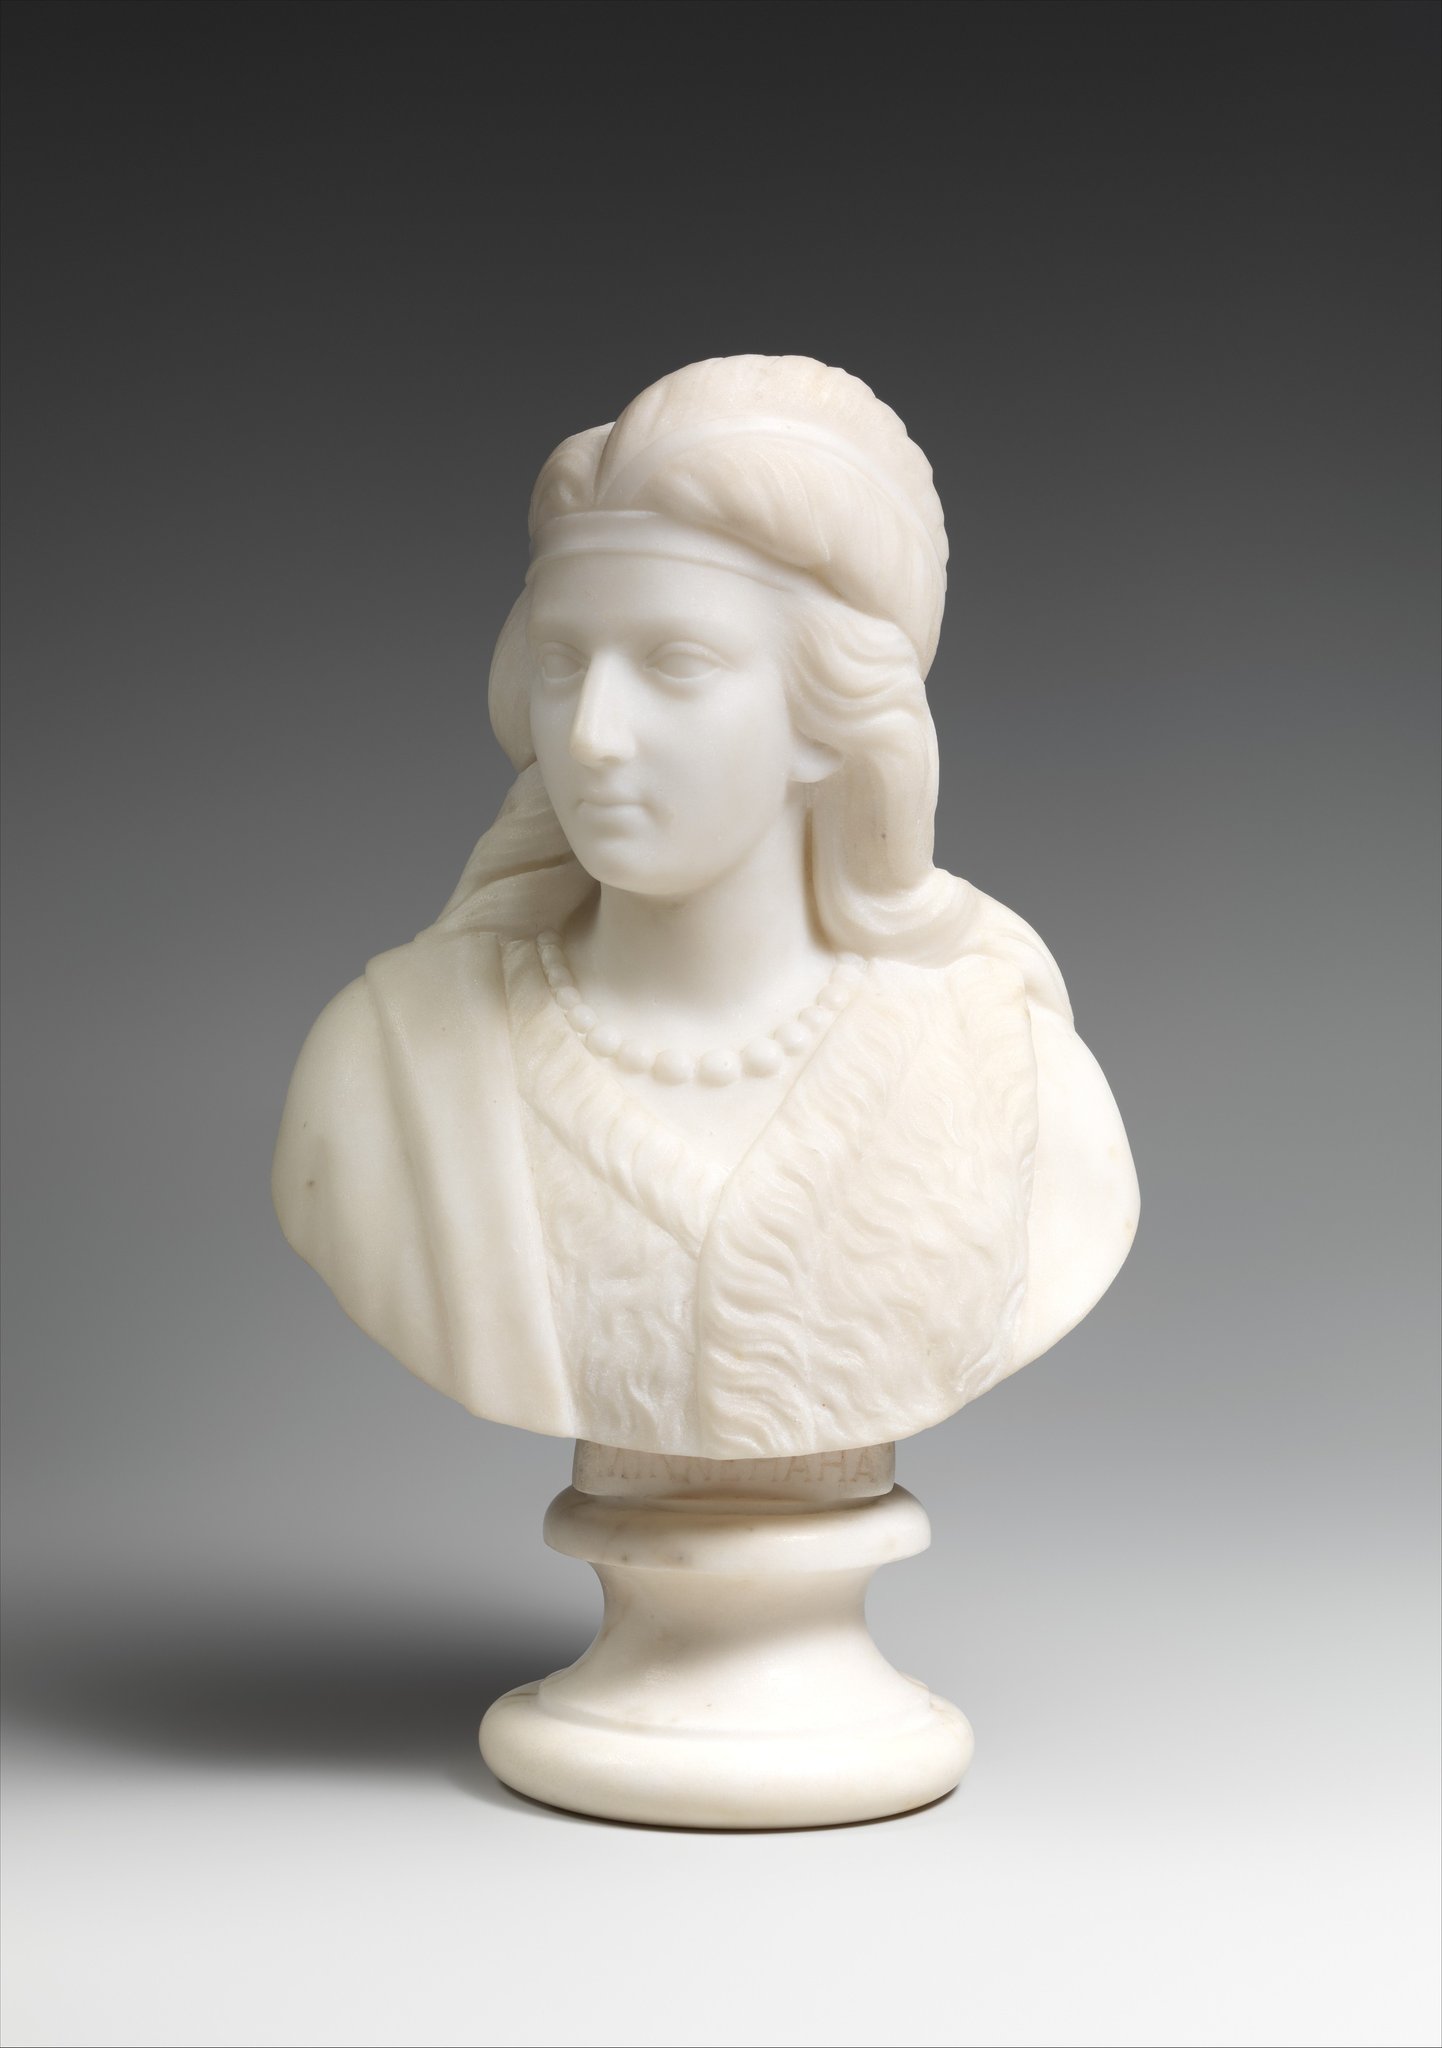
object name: bust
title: Minnehaha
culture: american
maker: edmonia lewis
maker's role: artist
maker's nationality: american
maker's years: 1844-1907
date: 1868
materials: marble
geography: italy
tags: women